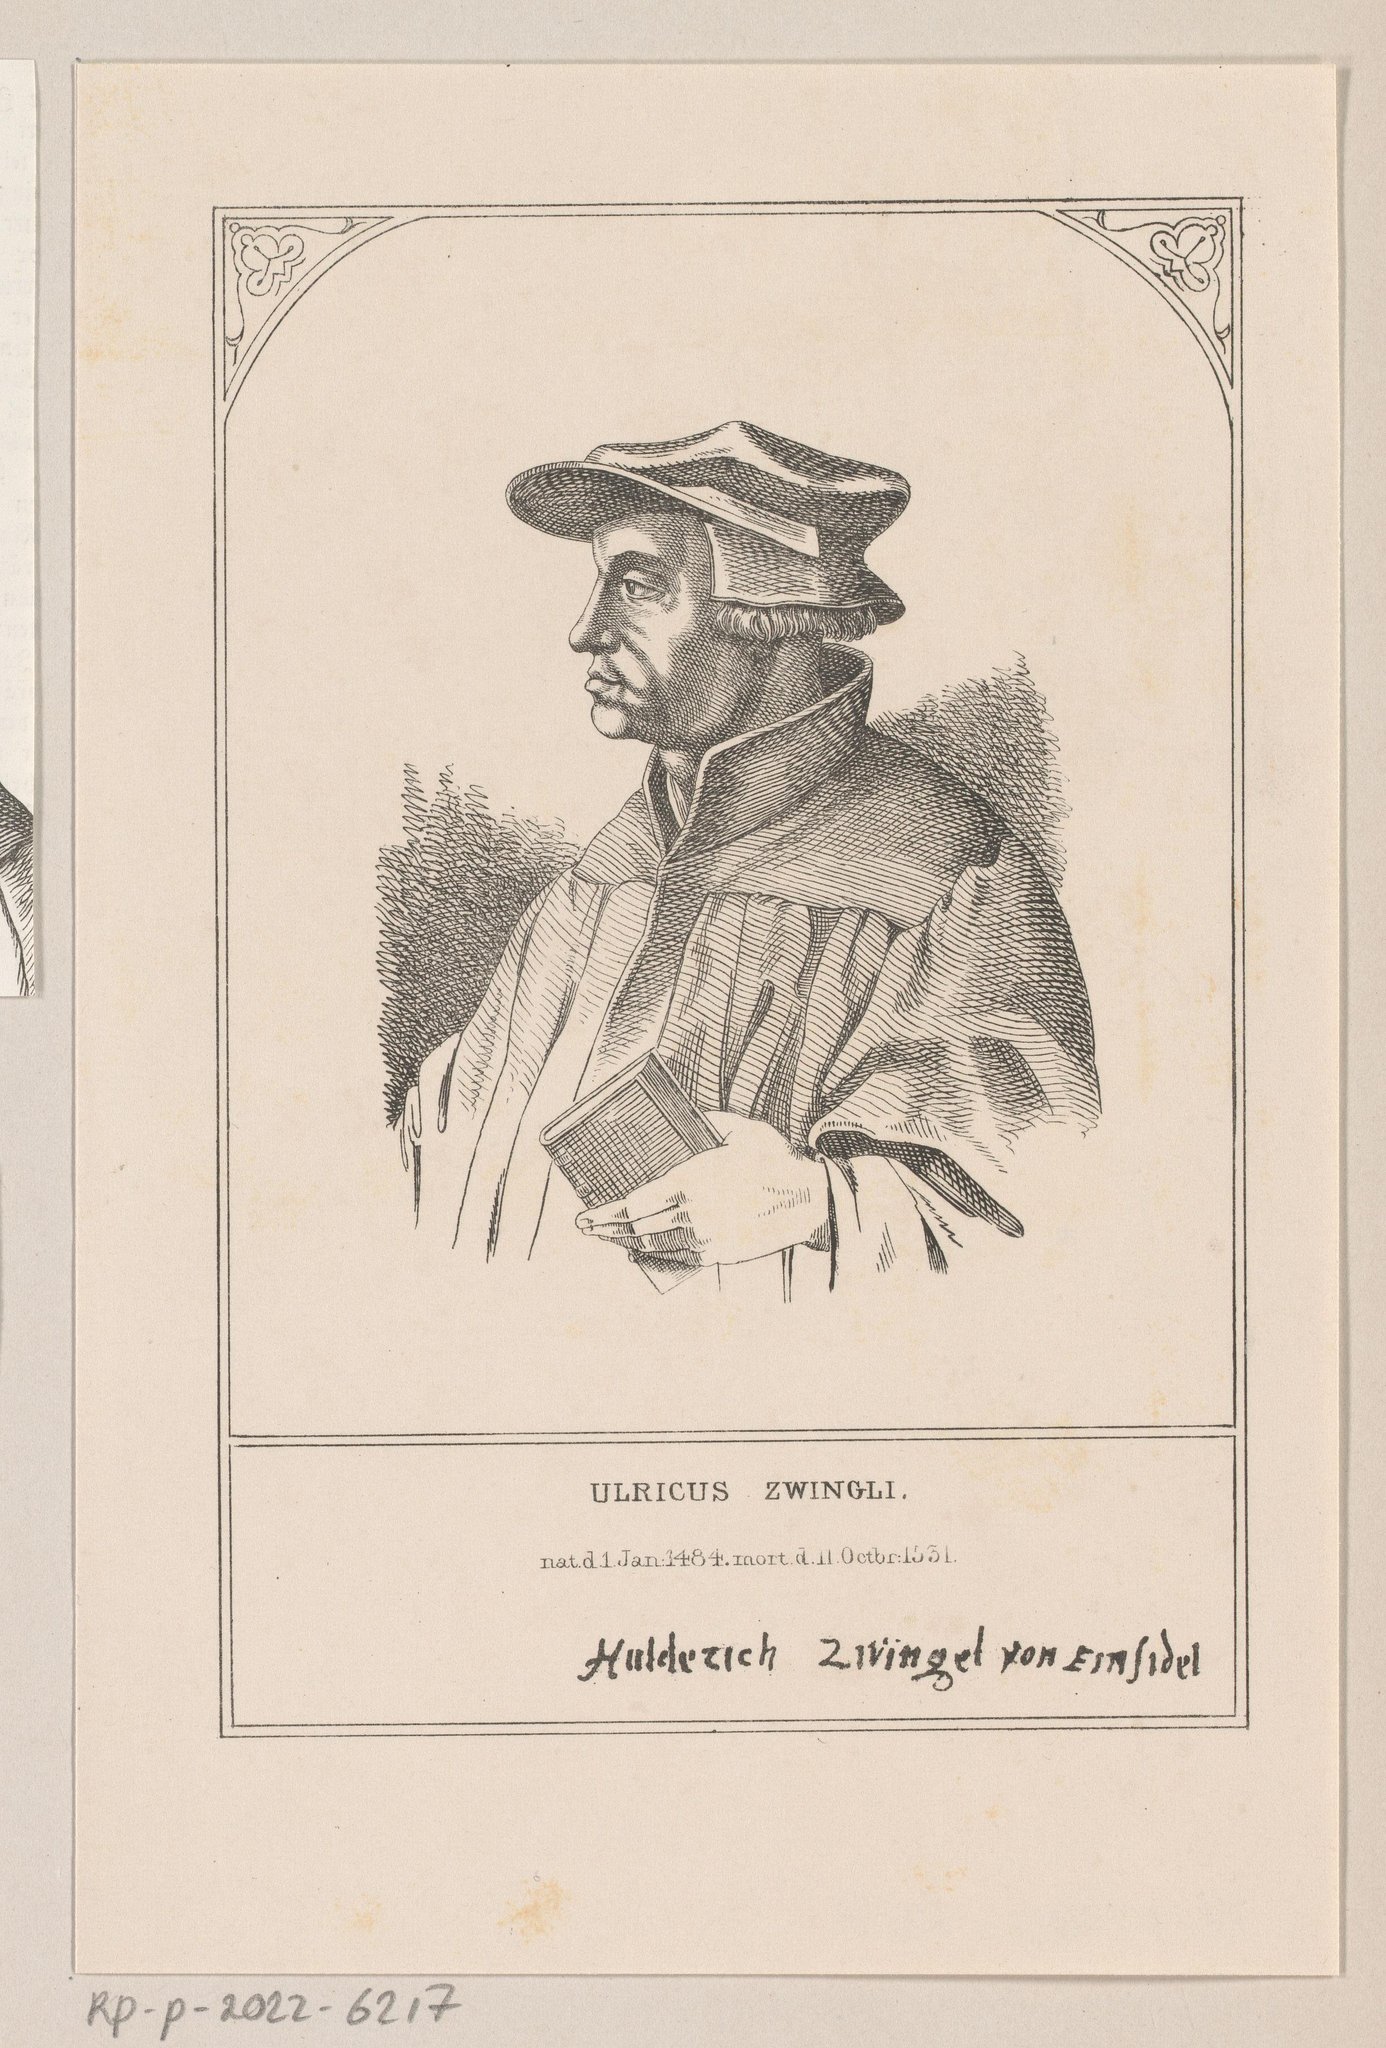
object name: book illustration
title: Portret van Ulrich Zwingli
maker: Anonymous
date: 1841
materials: paper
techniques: etching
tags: clergyman, theologian, historical persons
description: Prent waarschijnlijk uit: Neander, A.F. Vitae quatuor Reformatorum (...). Berlijn: G. Eichler, 1841.